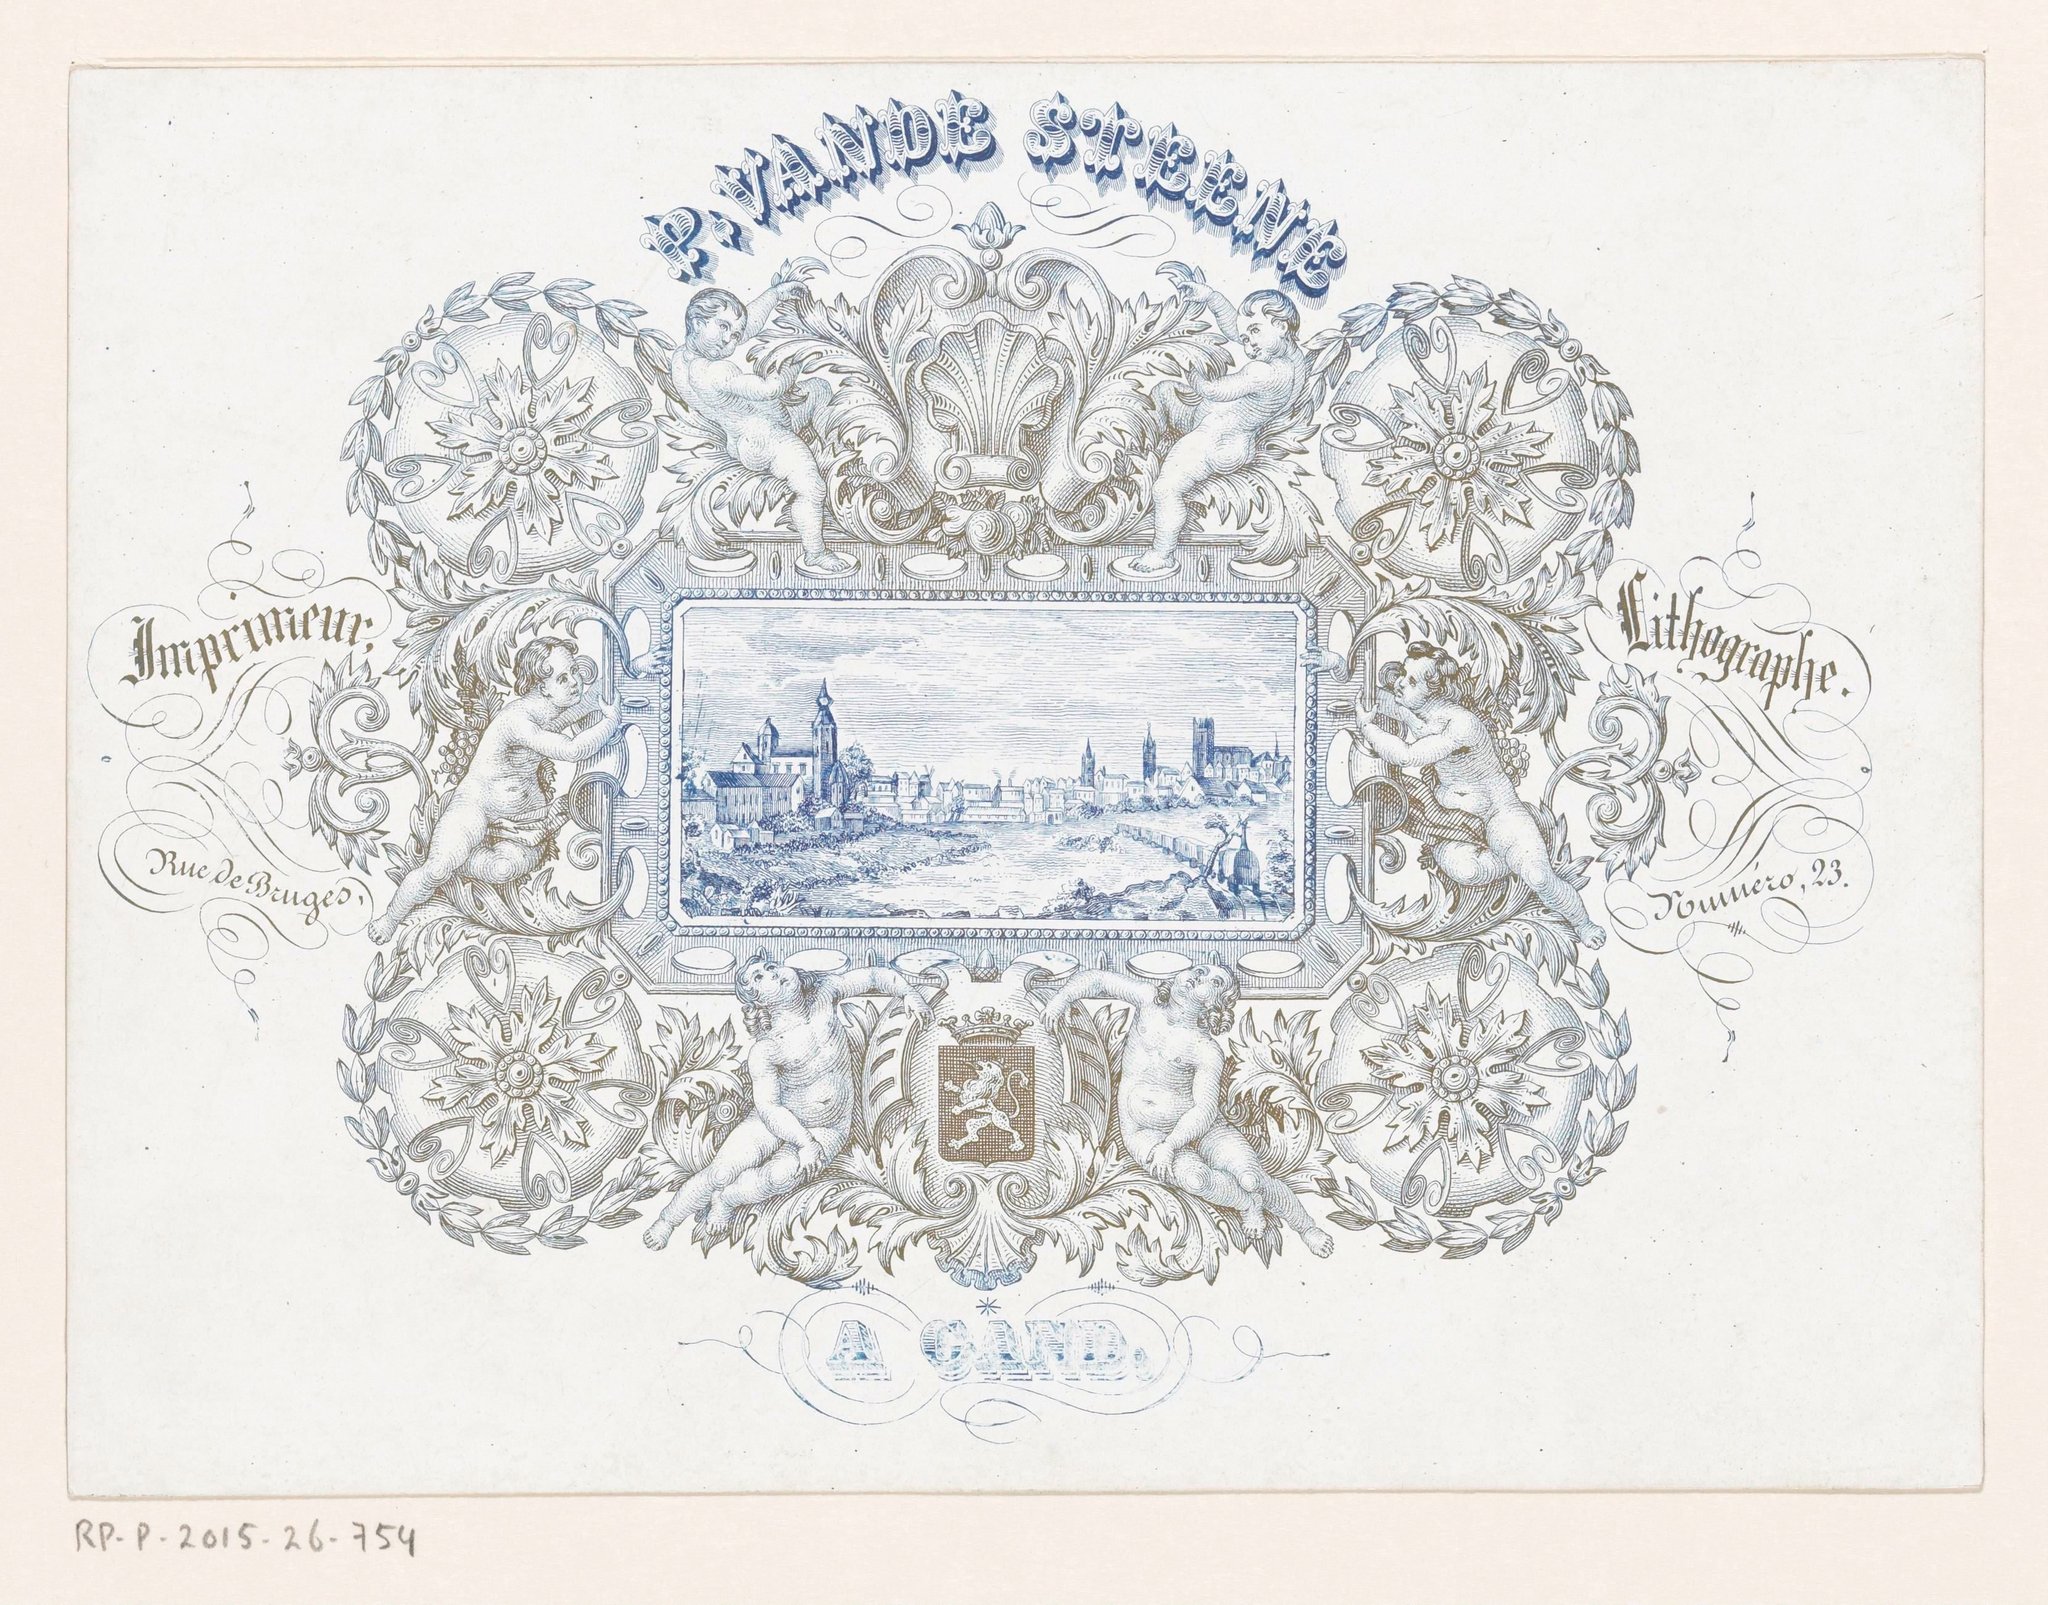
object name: visiting card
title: Visitekaartje van drukker Pierre Vande Steene te Gent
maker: pierre vande steene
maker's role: print maker, printer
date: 1841-1854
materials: porcelainized cardboard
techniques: lithograph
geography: ghent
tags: coat of arms (as symbol of the state, etc.), railway, train, cupids: 'amores', 'amoretti', 'putti', prospect of city, town panorama, silhouette of city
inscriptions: collector's mark: Lugt 2228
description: Gezicht op de stad Gent met in de voorgrond een stoomtrein, in decoratieve omlijsting met zes putti waarvan de onderste twee het wapen van België vasthouden.